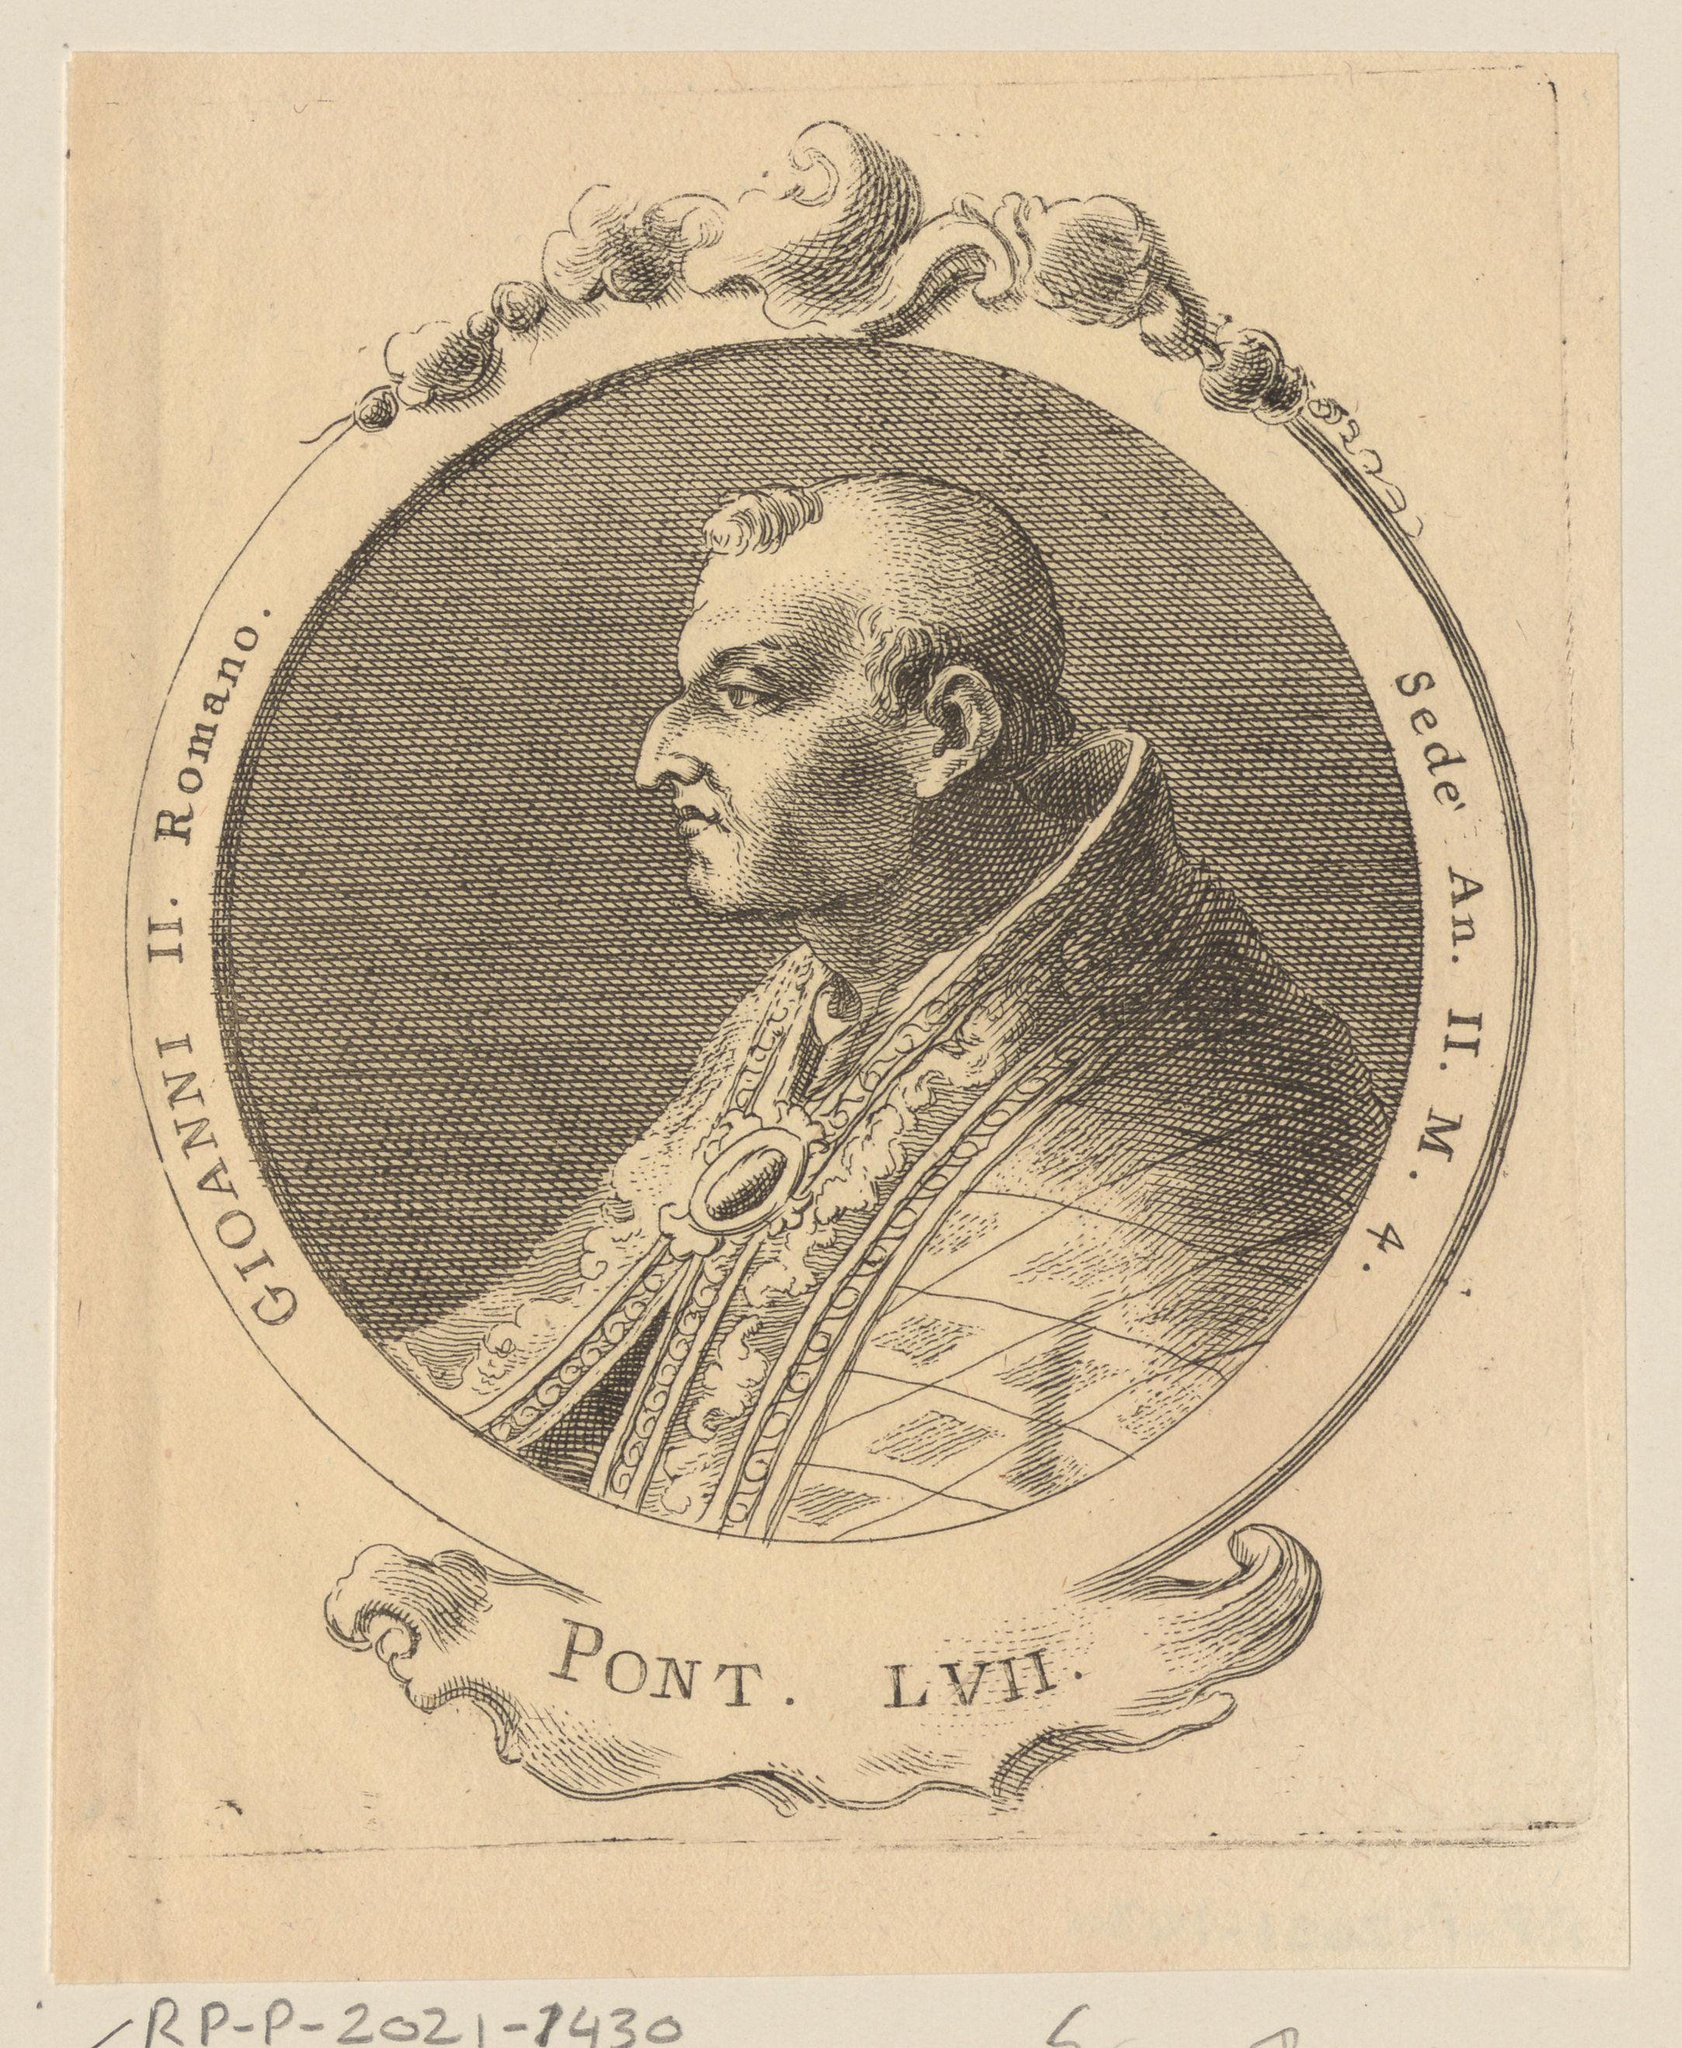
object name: print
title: Portret van paus Johannes II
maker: Anonymous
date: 1760-1775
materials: paper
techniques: etching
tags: rome, historical persons, pope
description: Prent waarschijnlijk uit: Effigies Romanorum pontificum a S. Petro ad Pium VI (...). 2 dln. Venetië en Bassano del Grappa: Giuseppe Remondini, 1775. Prent met tekst op verso gebruikt in: Platina (Bartholomaeus Sacchi). Storia delle vite dei pontefici da Platina e d'altri autori (...). Venetië: Domenico Ferrarin, 1760, dl. 1, p. 236.